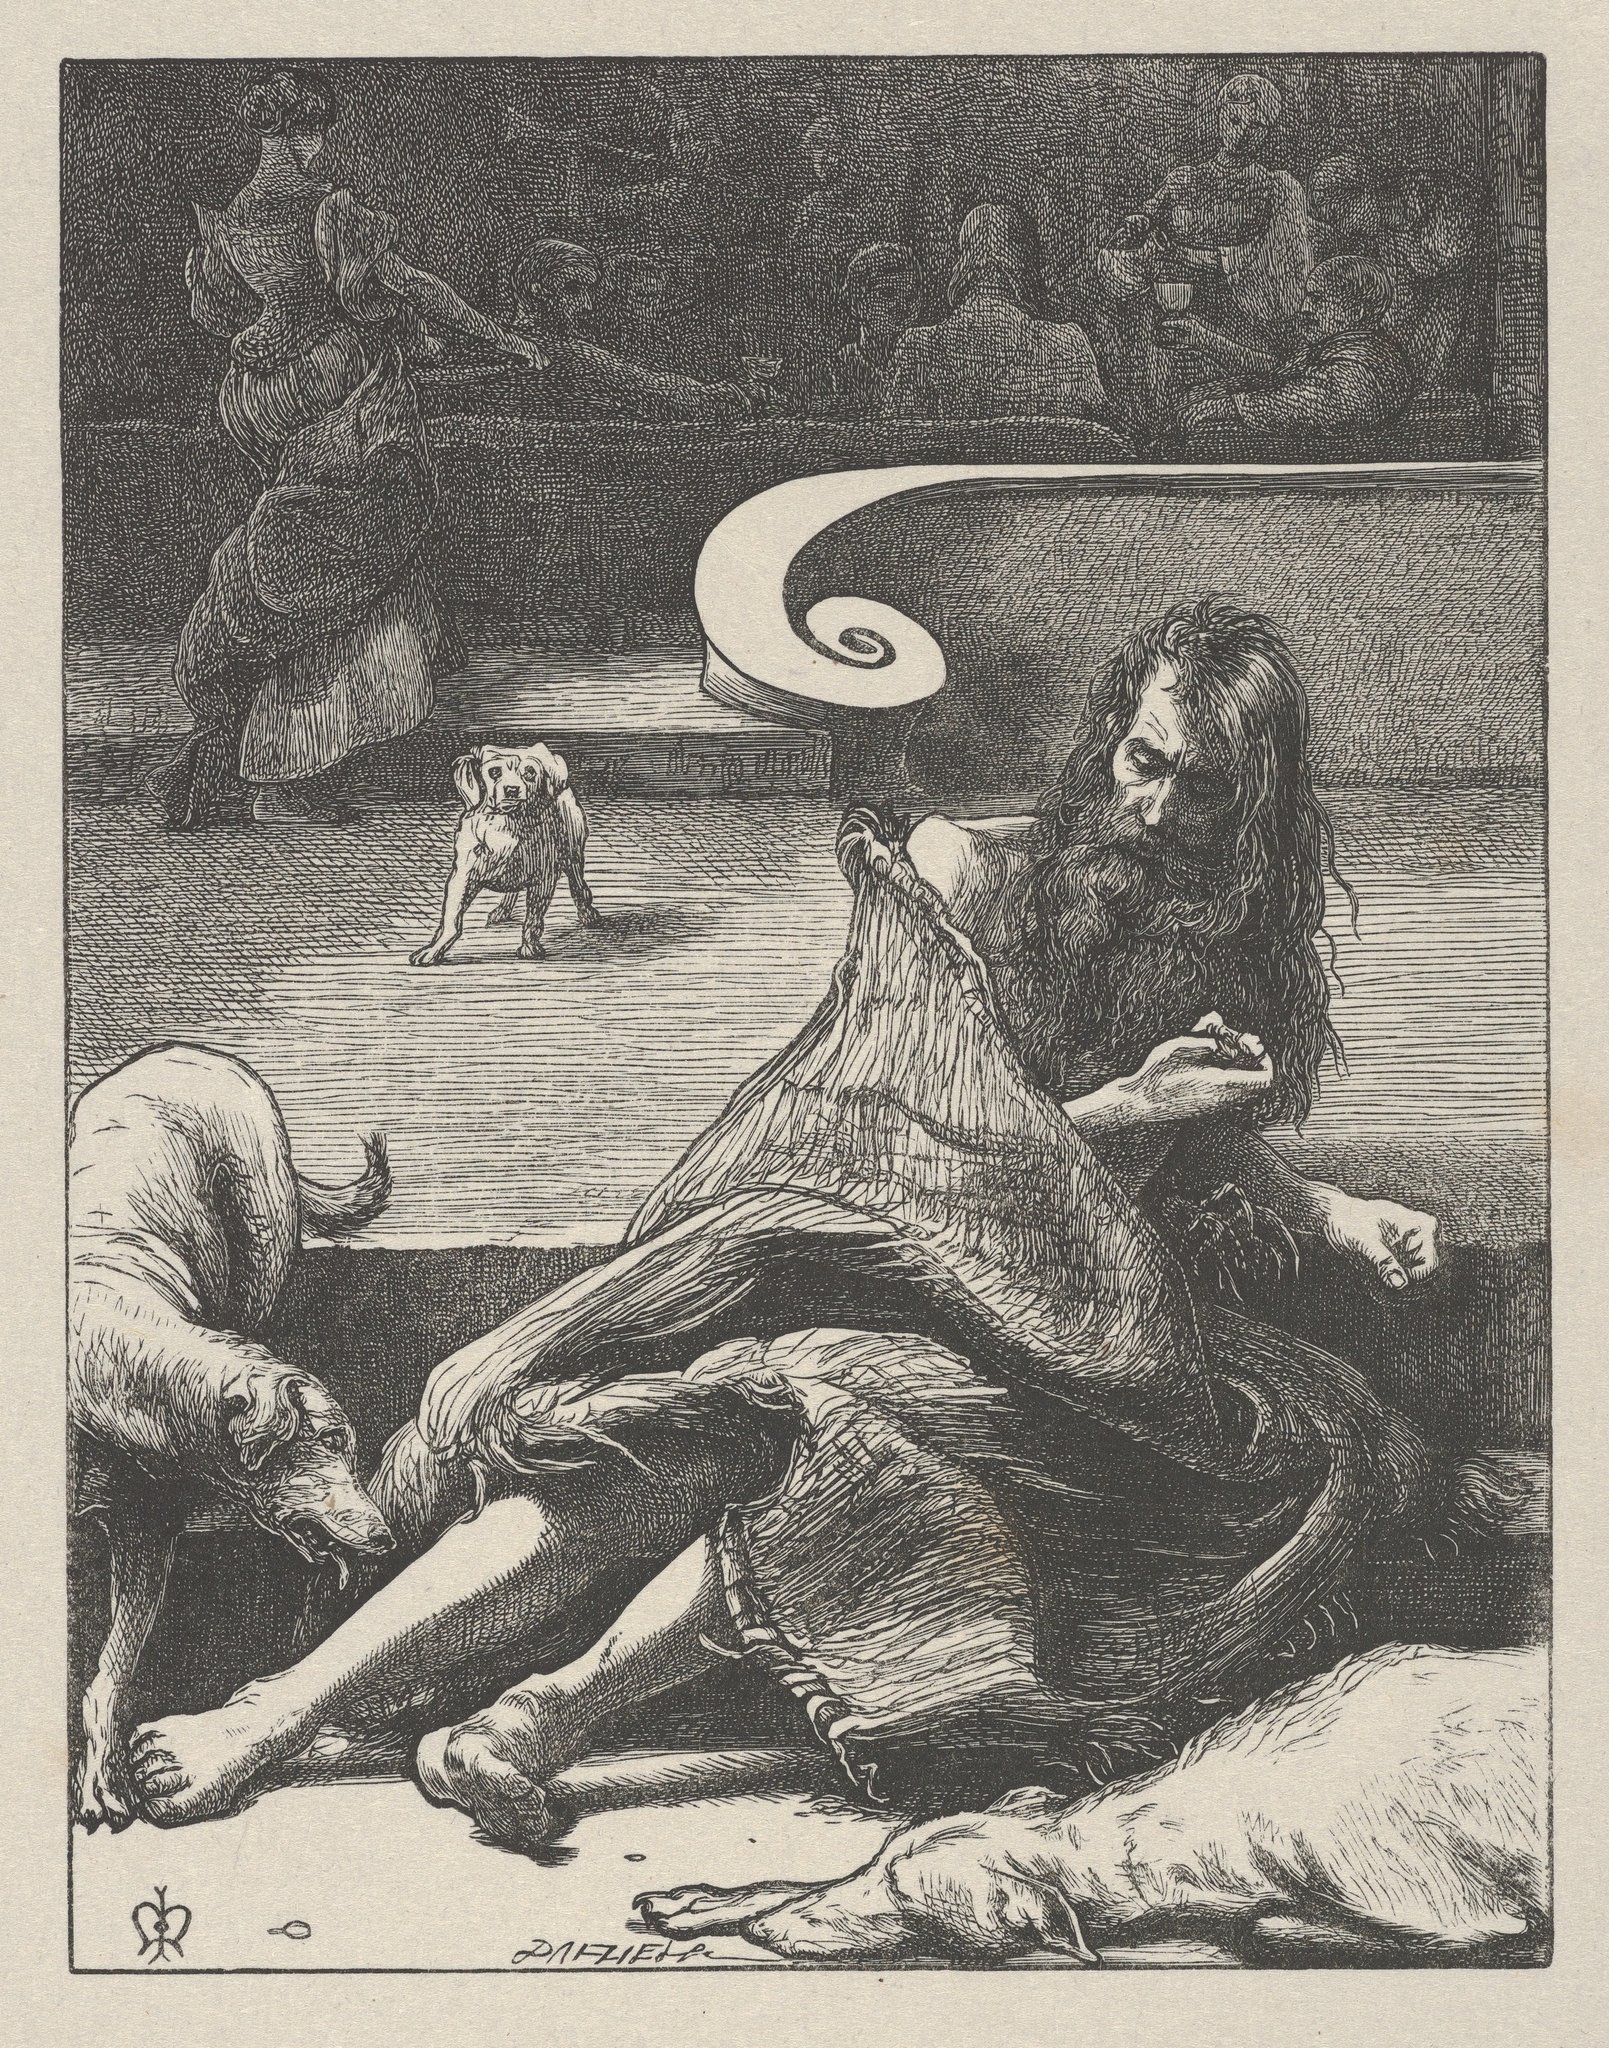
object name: print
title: The Rich Man and Lazarus (The Parables of Our Lord and Saviour Jesus Christ)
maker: sir john everett millais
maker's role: artist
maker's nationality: british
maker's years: 1829-1896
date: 1864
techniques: engraving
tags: men,women,dogs,jesus,saints,parables